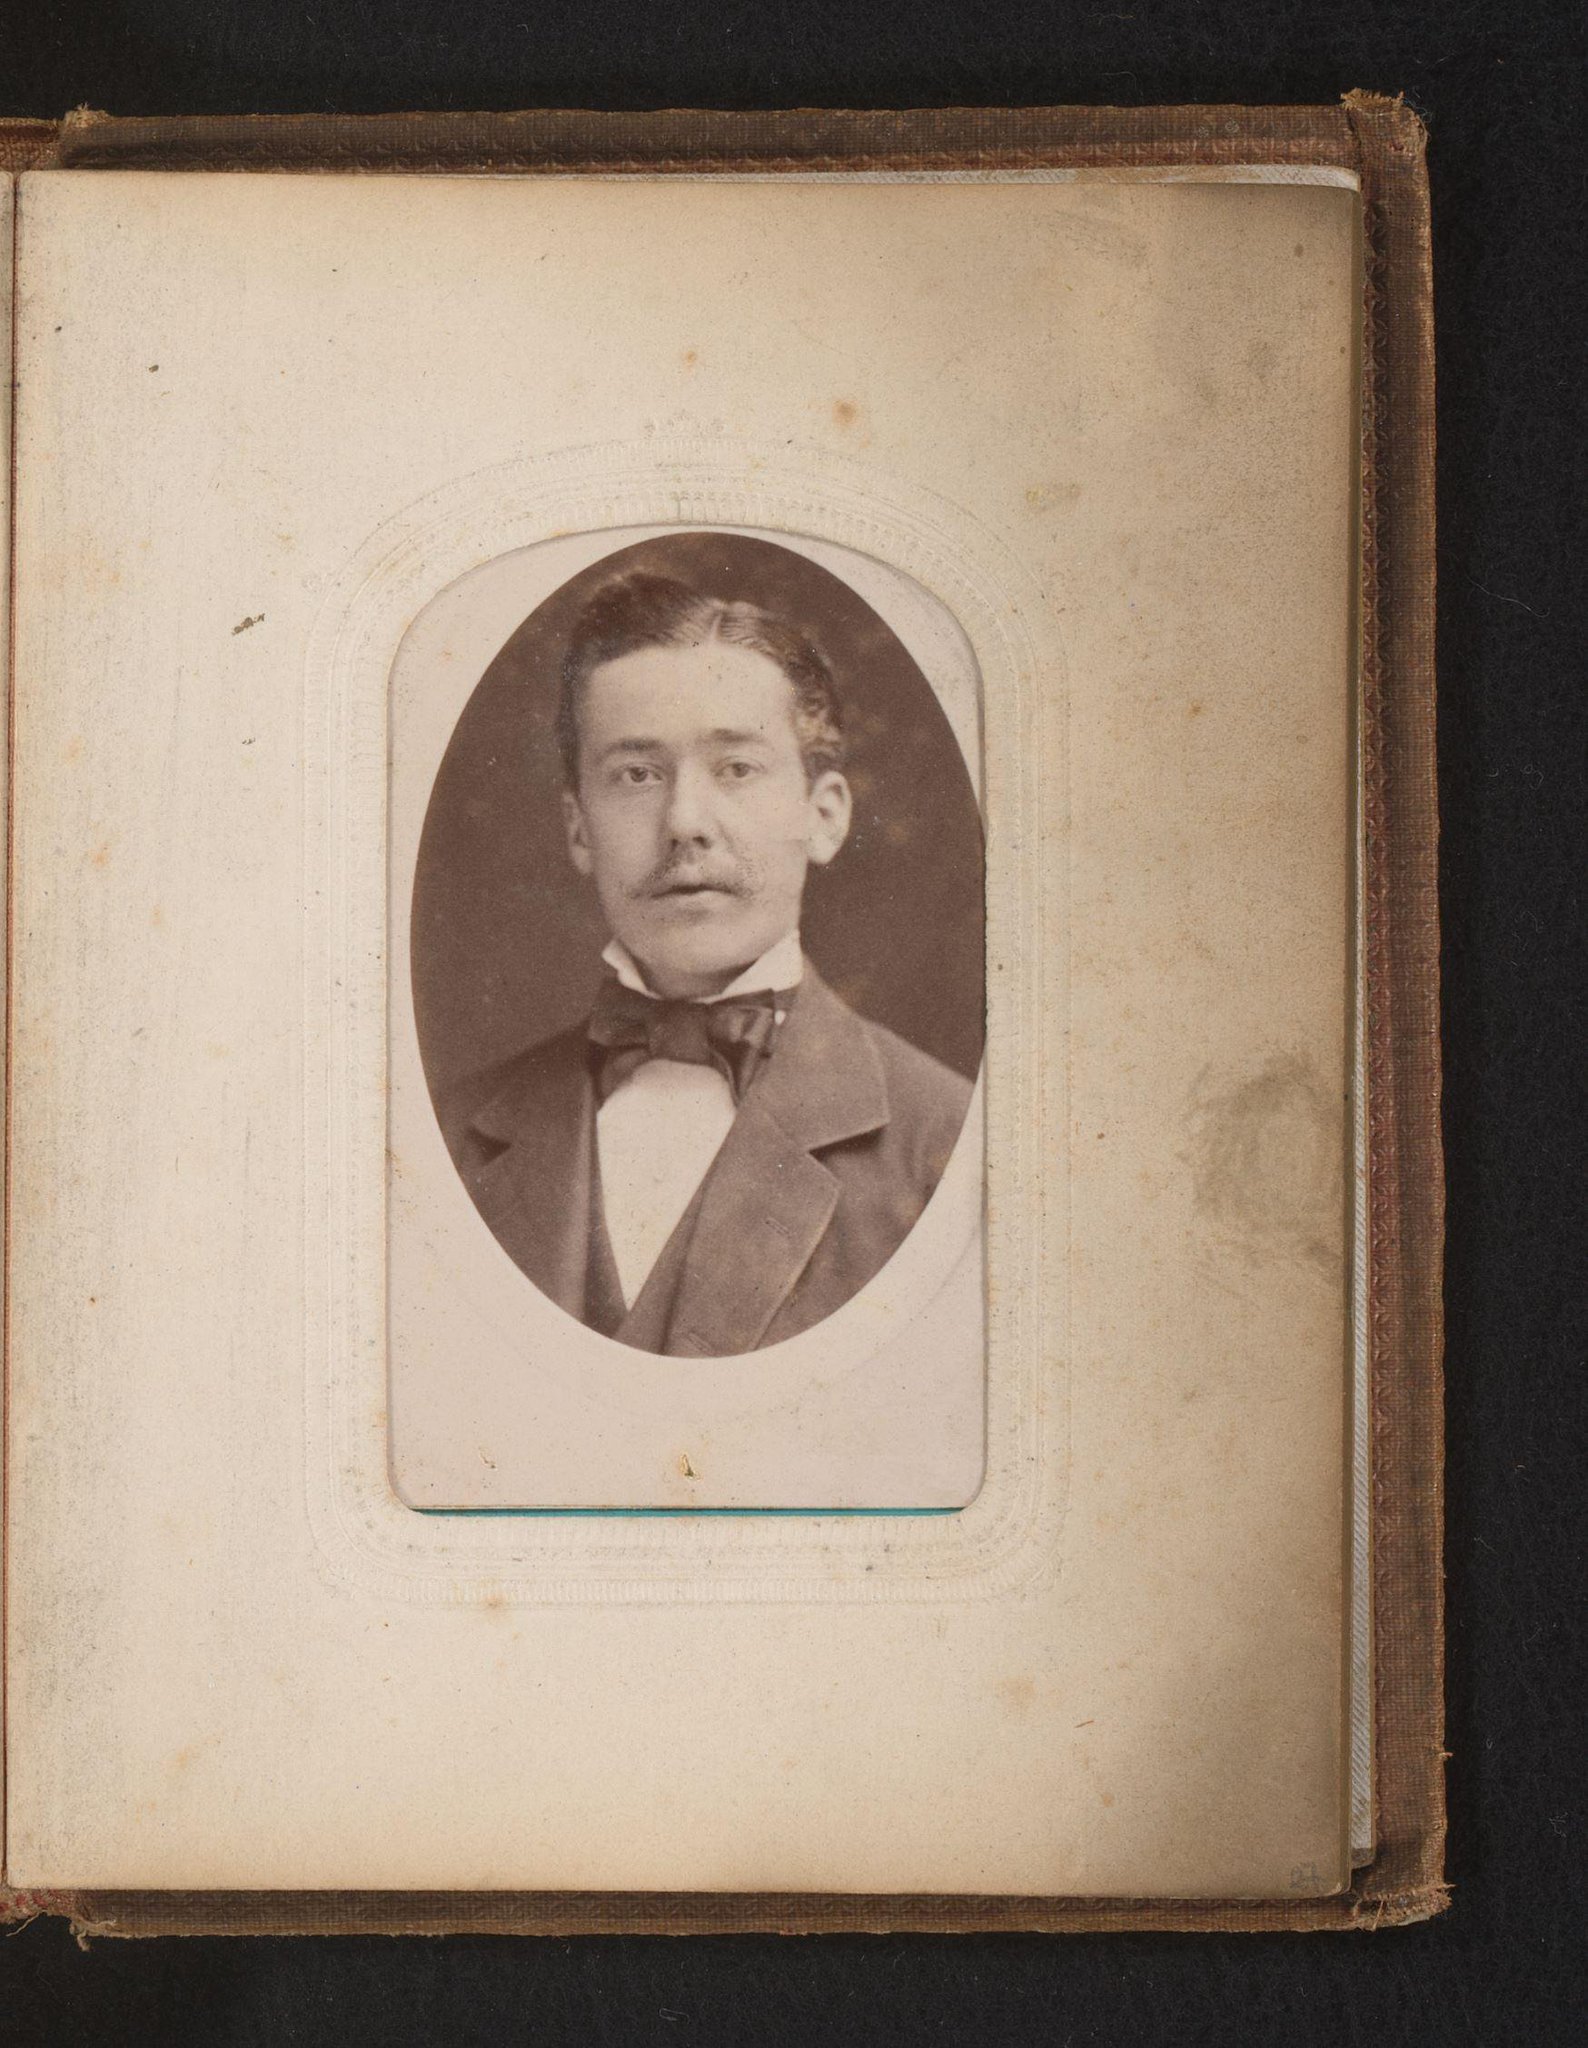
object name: photograph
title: Portret van een man met snor en vlinderstrik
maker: carl g. kesseler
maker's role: fotograaf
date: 1875-1900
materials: cardboard, celluloid, photographic support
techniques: albumen print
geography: frankfurt am main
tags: moustache, historical persons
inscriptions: inscription: ‘(...)/ Anerkennungs/ DIPLOM/ WIEN 1875/ Carl G. Kesseler/ Hof-Photograph/ in/ Frankfurt am Main/ Eschersheimer Landstrasse No 5/ Die Platte bleibt zum Nachbestellen reservirt.’